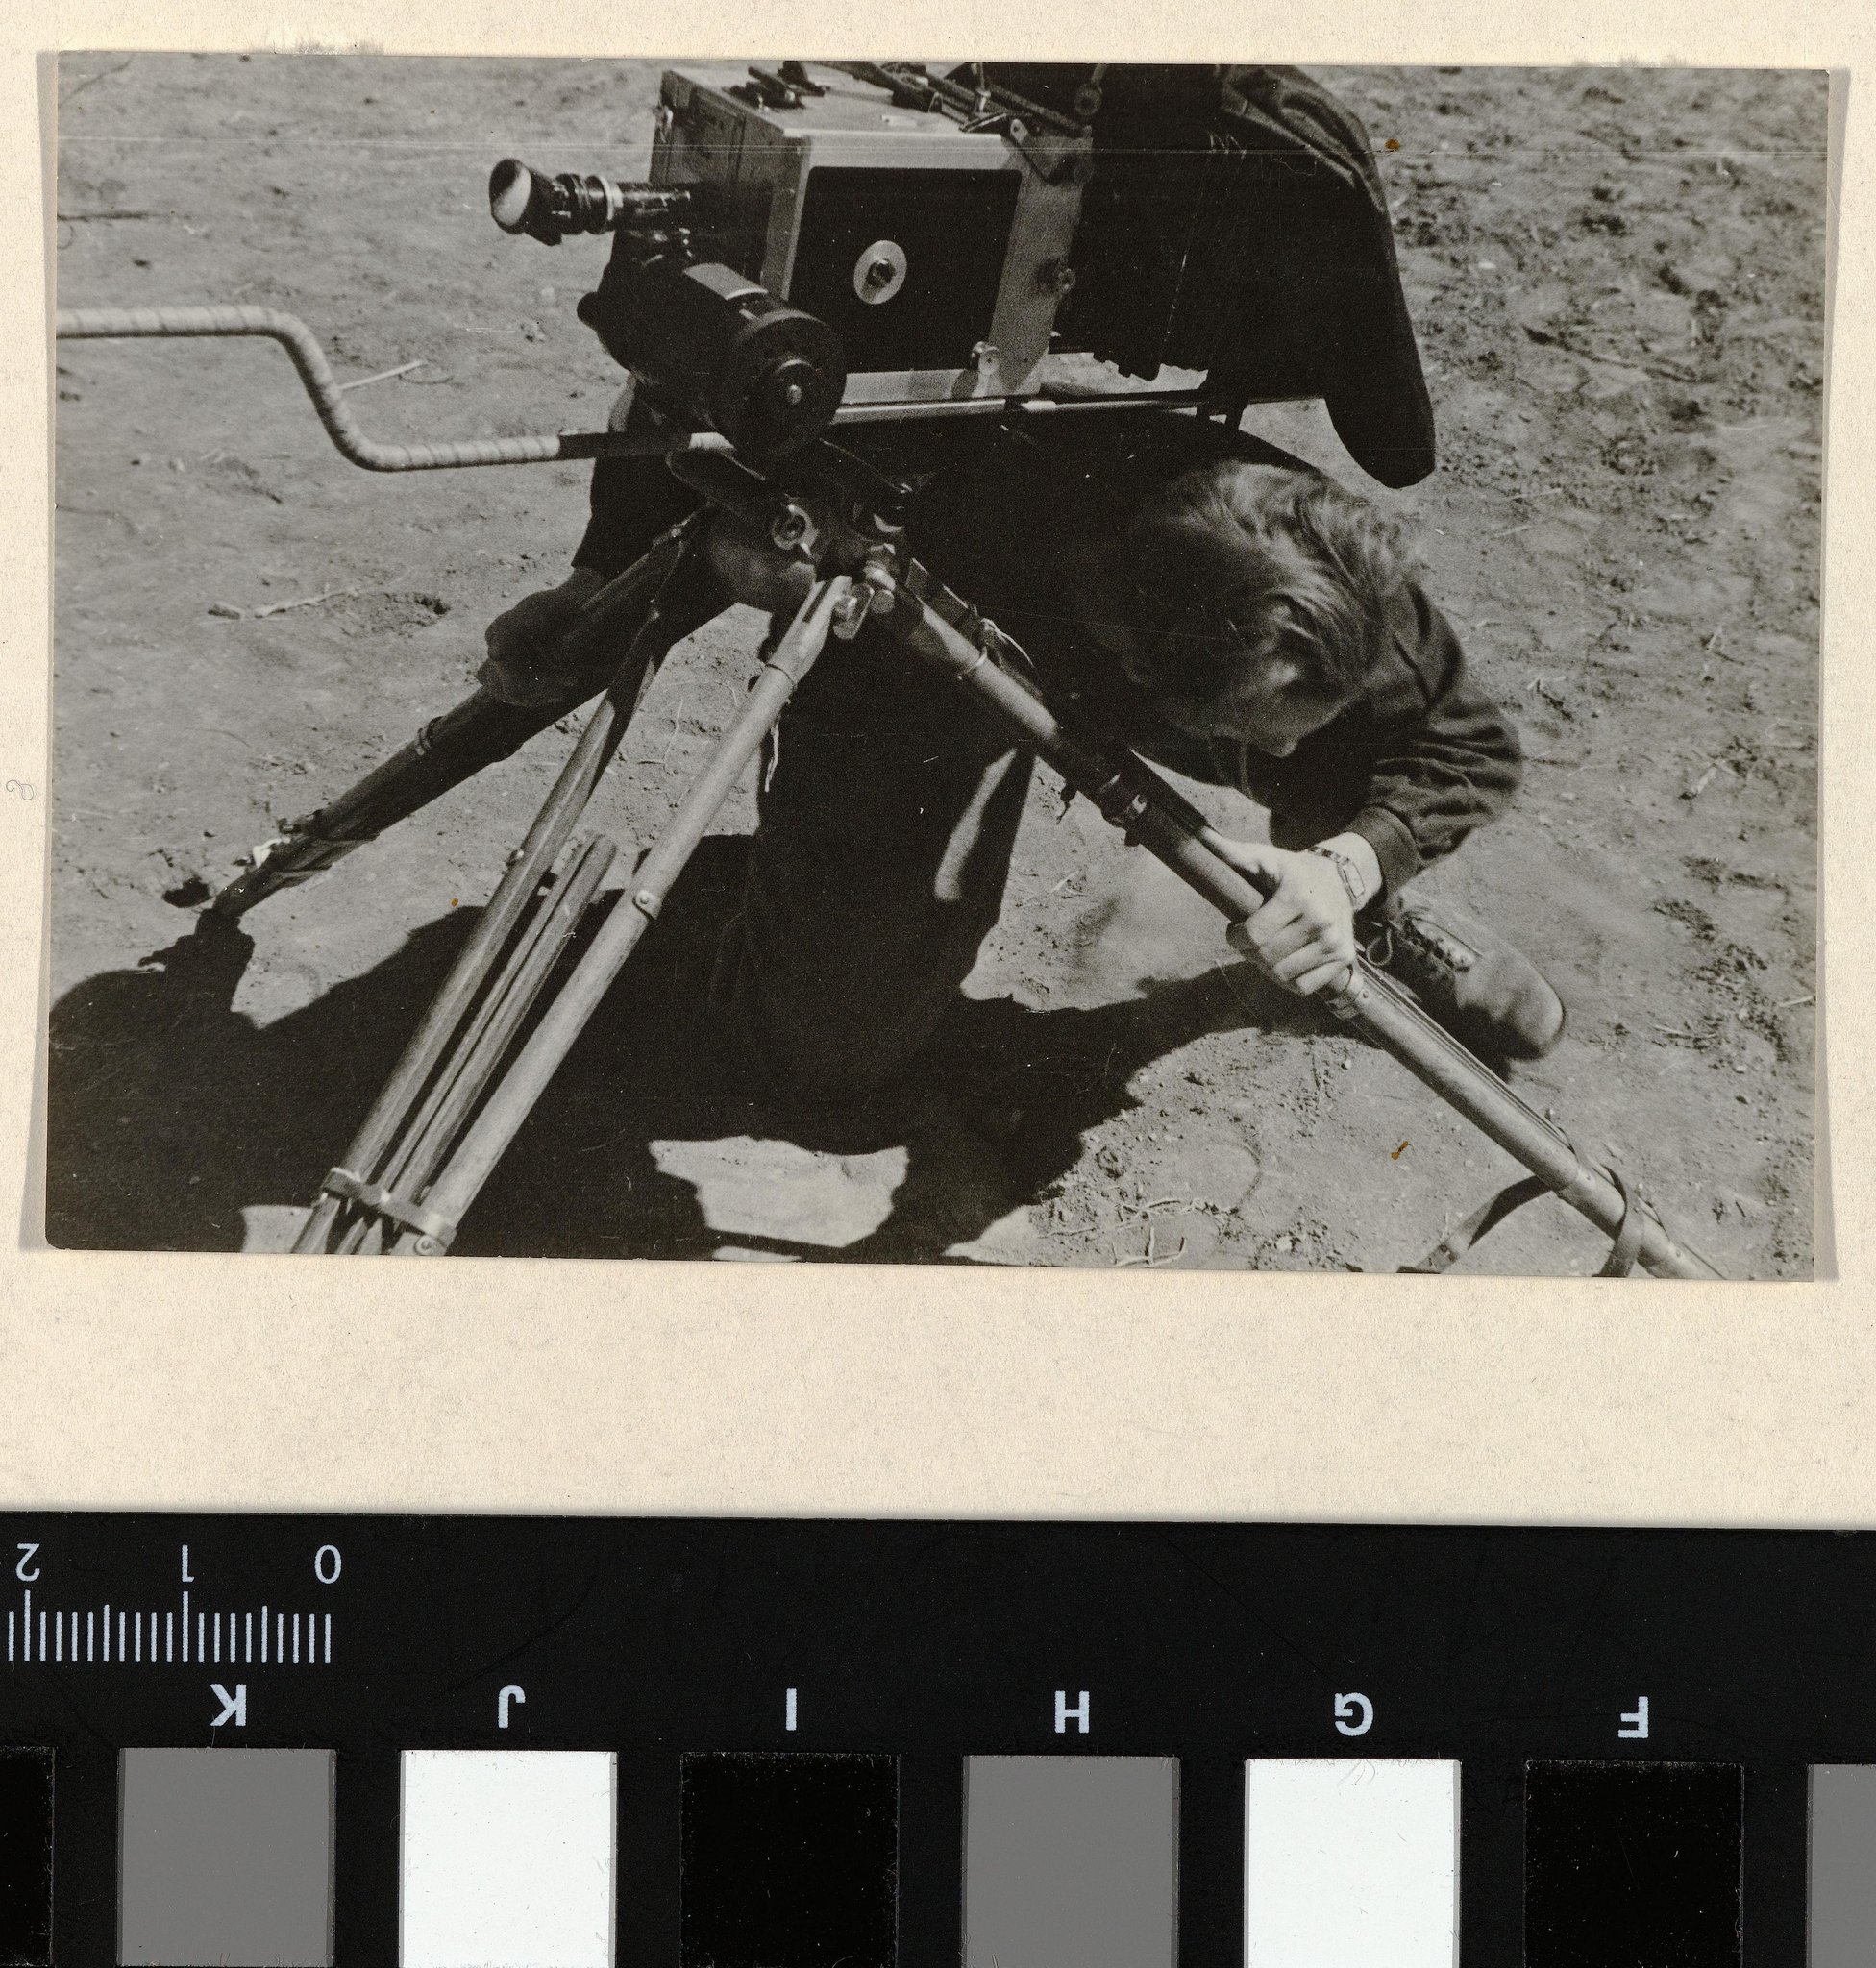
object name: photograph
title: John Fernhout met een camera in China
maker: robert capa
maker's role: fotograaf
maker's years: 1913-1954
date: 1938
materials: paper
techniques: gelatin silver print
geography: china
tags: john fernhout, filming, cinematographer at work - cc - out of doors, china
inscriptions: stamp: ‘K 295’